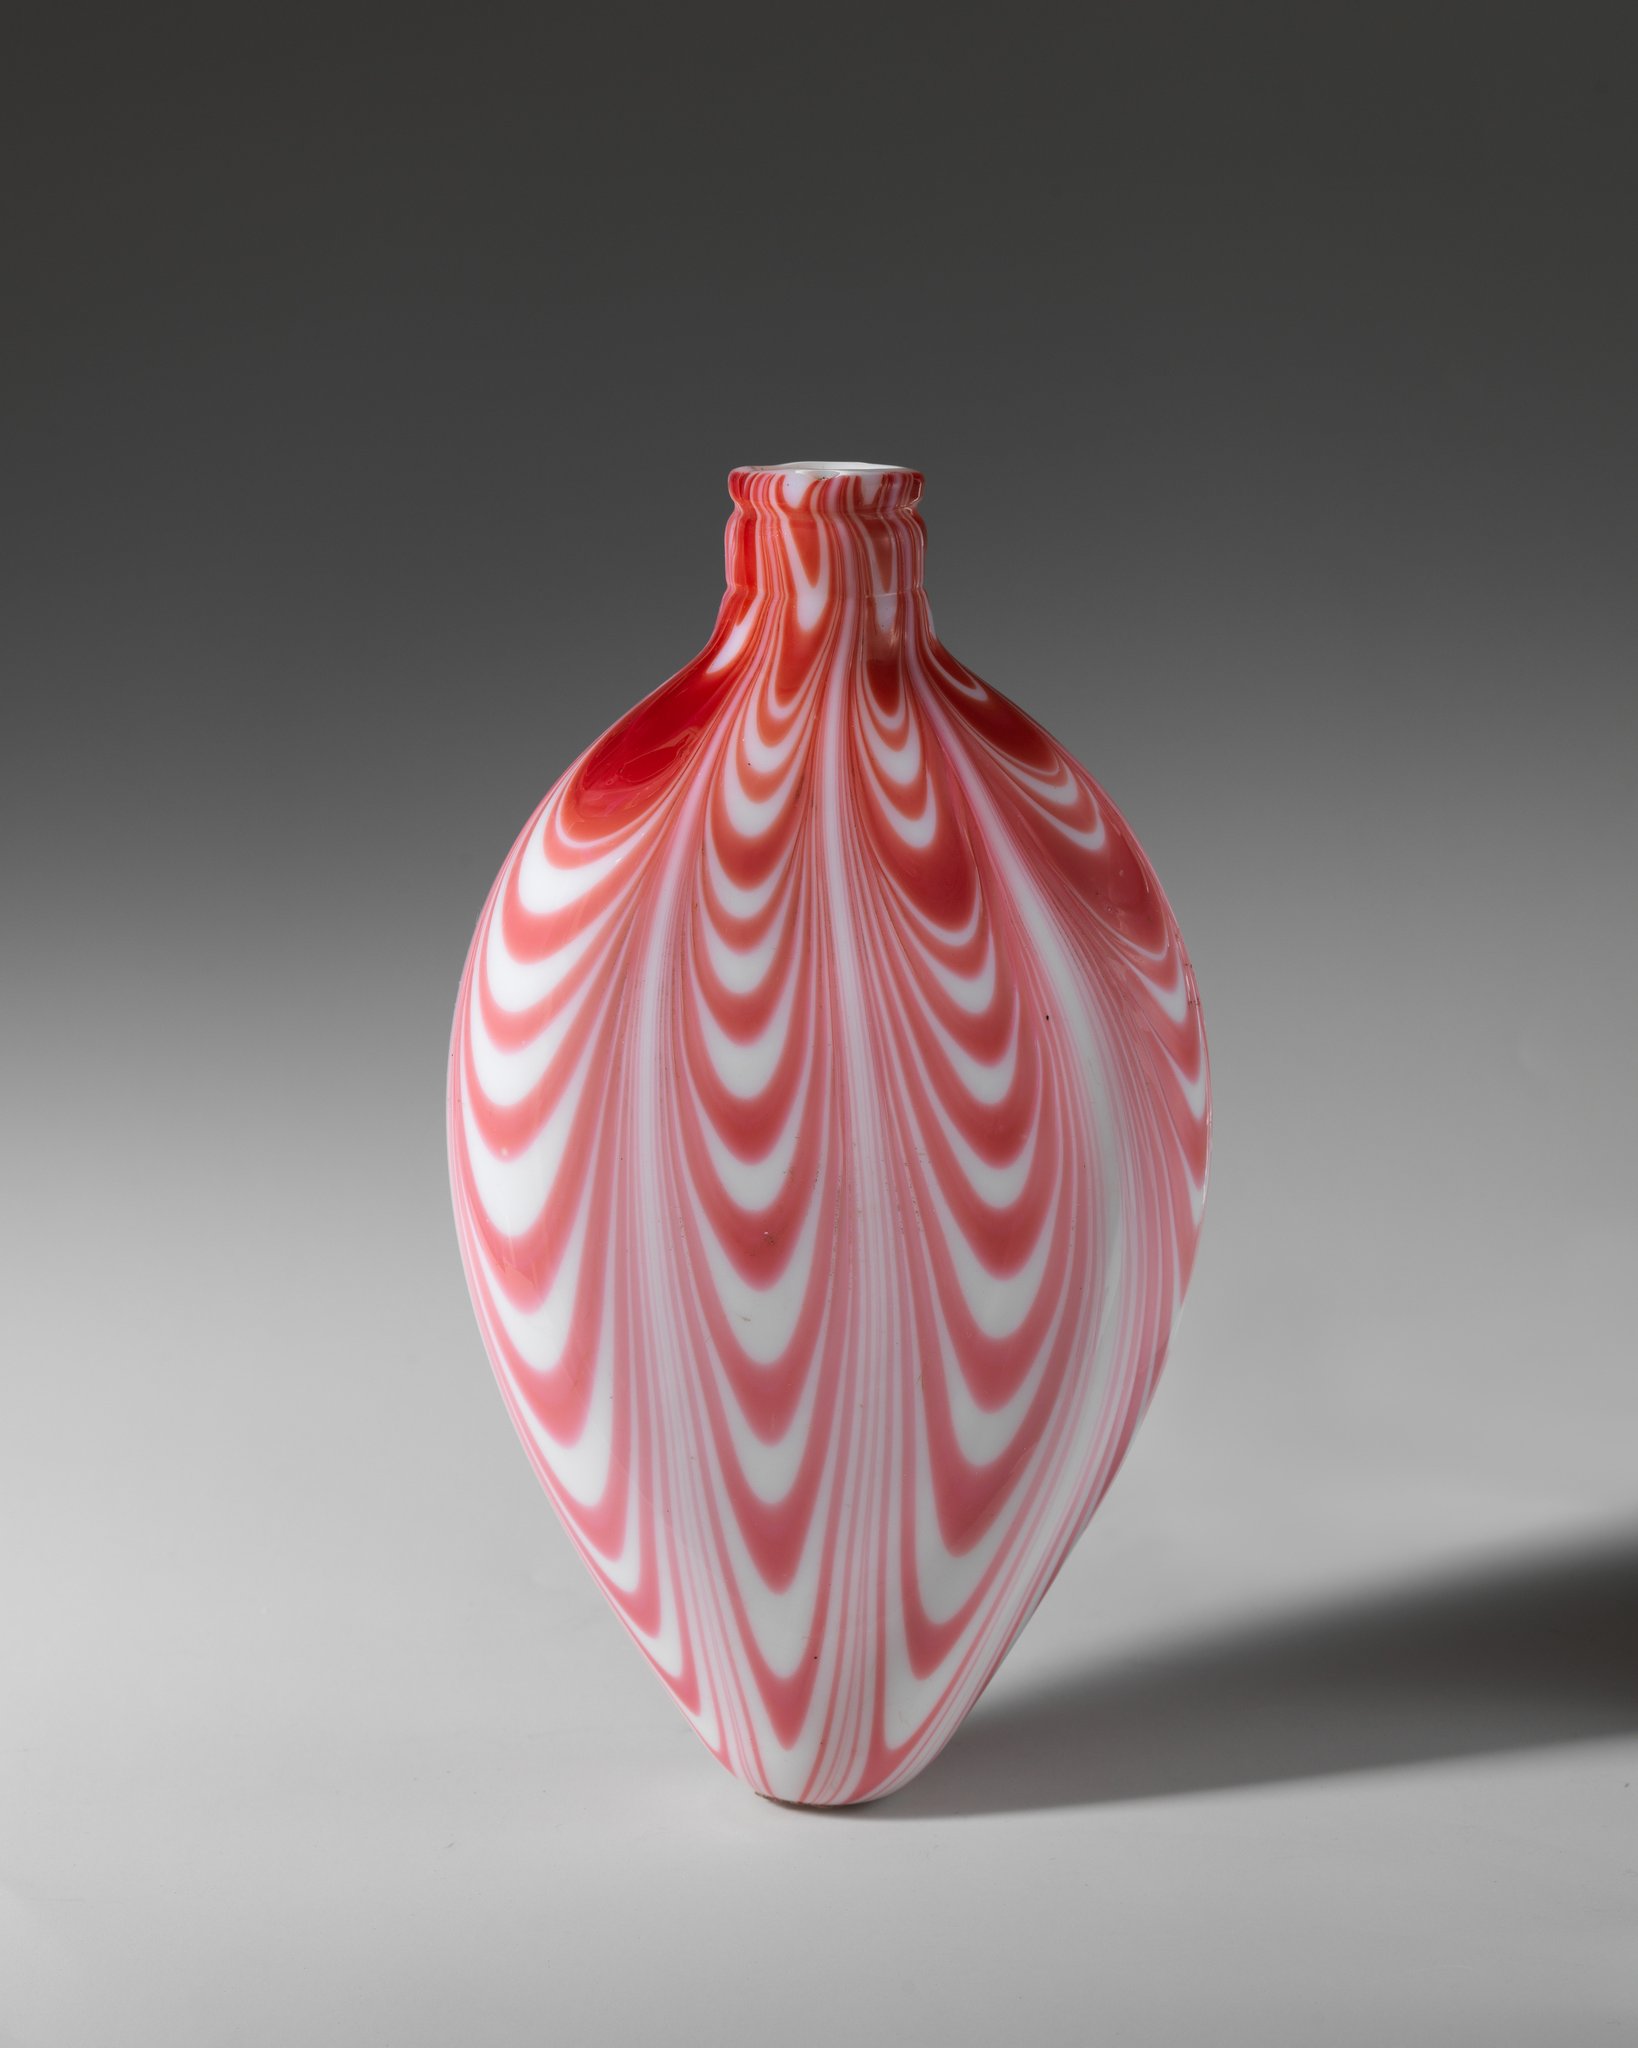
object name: flask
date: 1767-1833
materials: glass